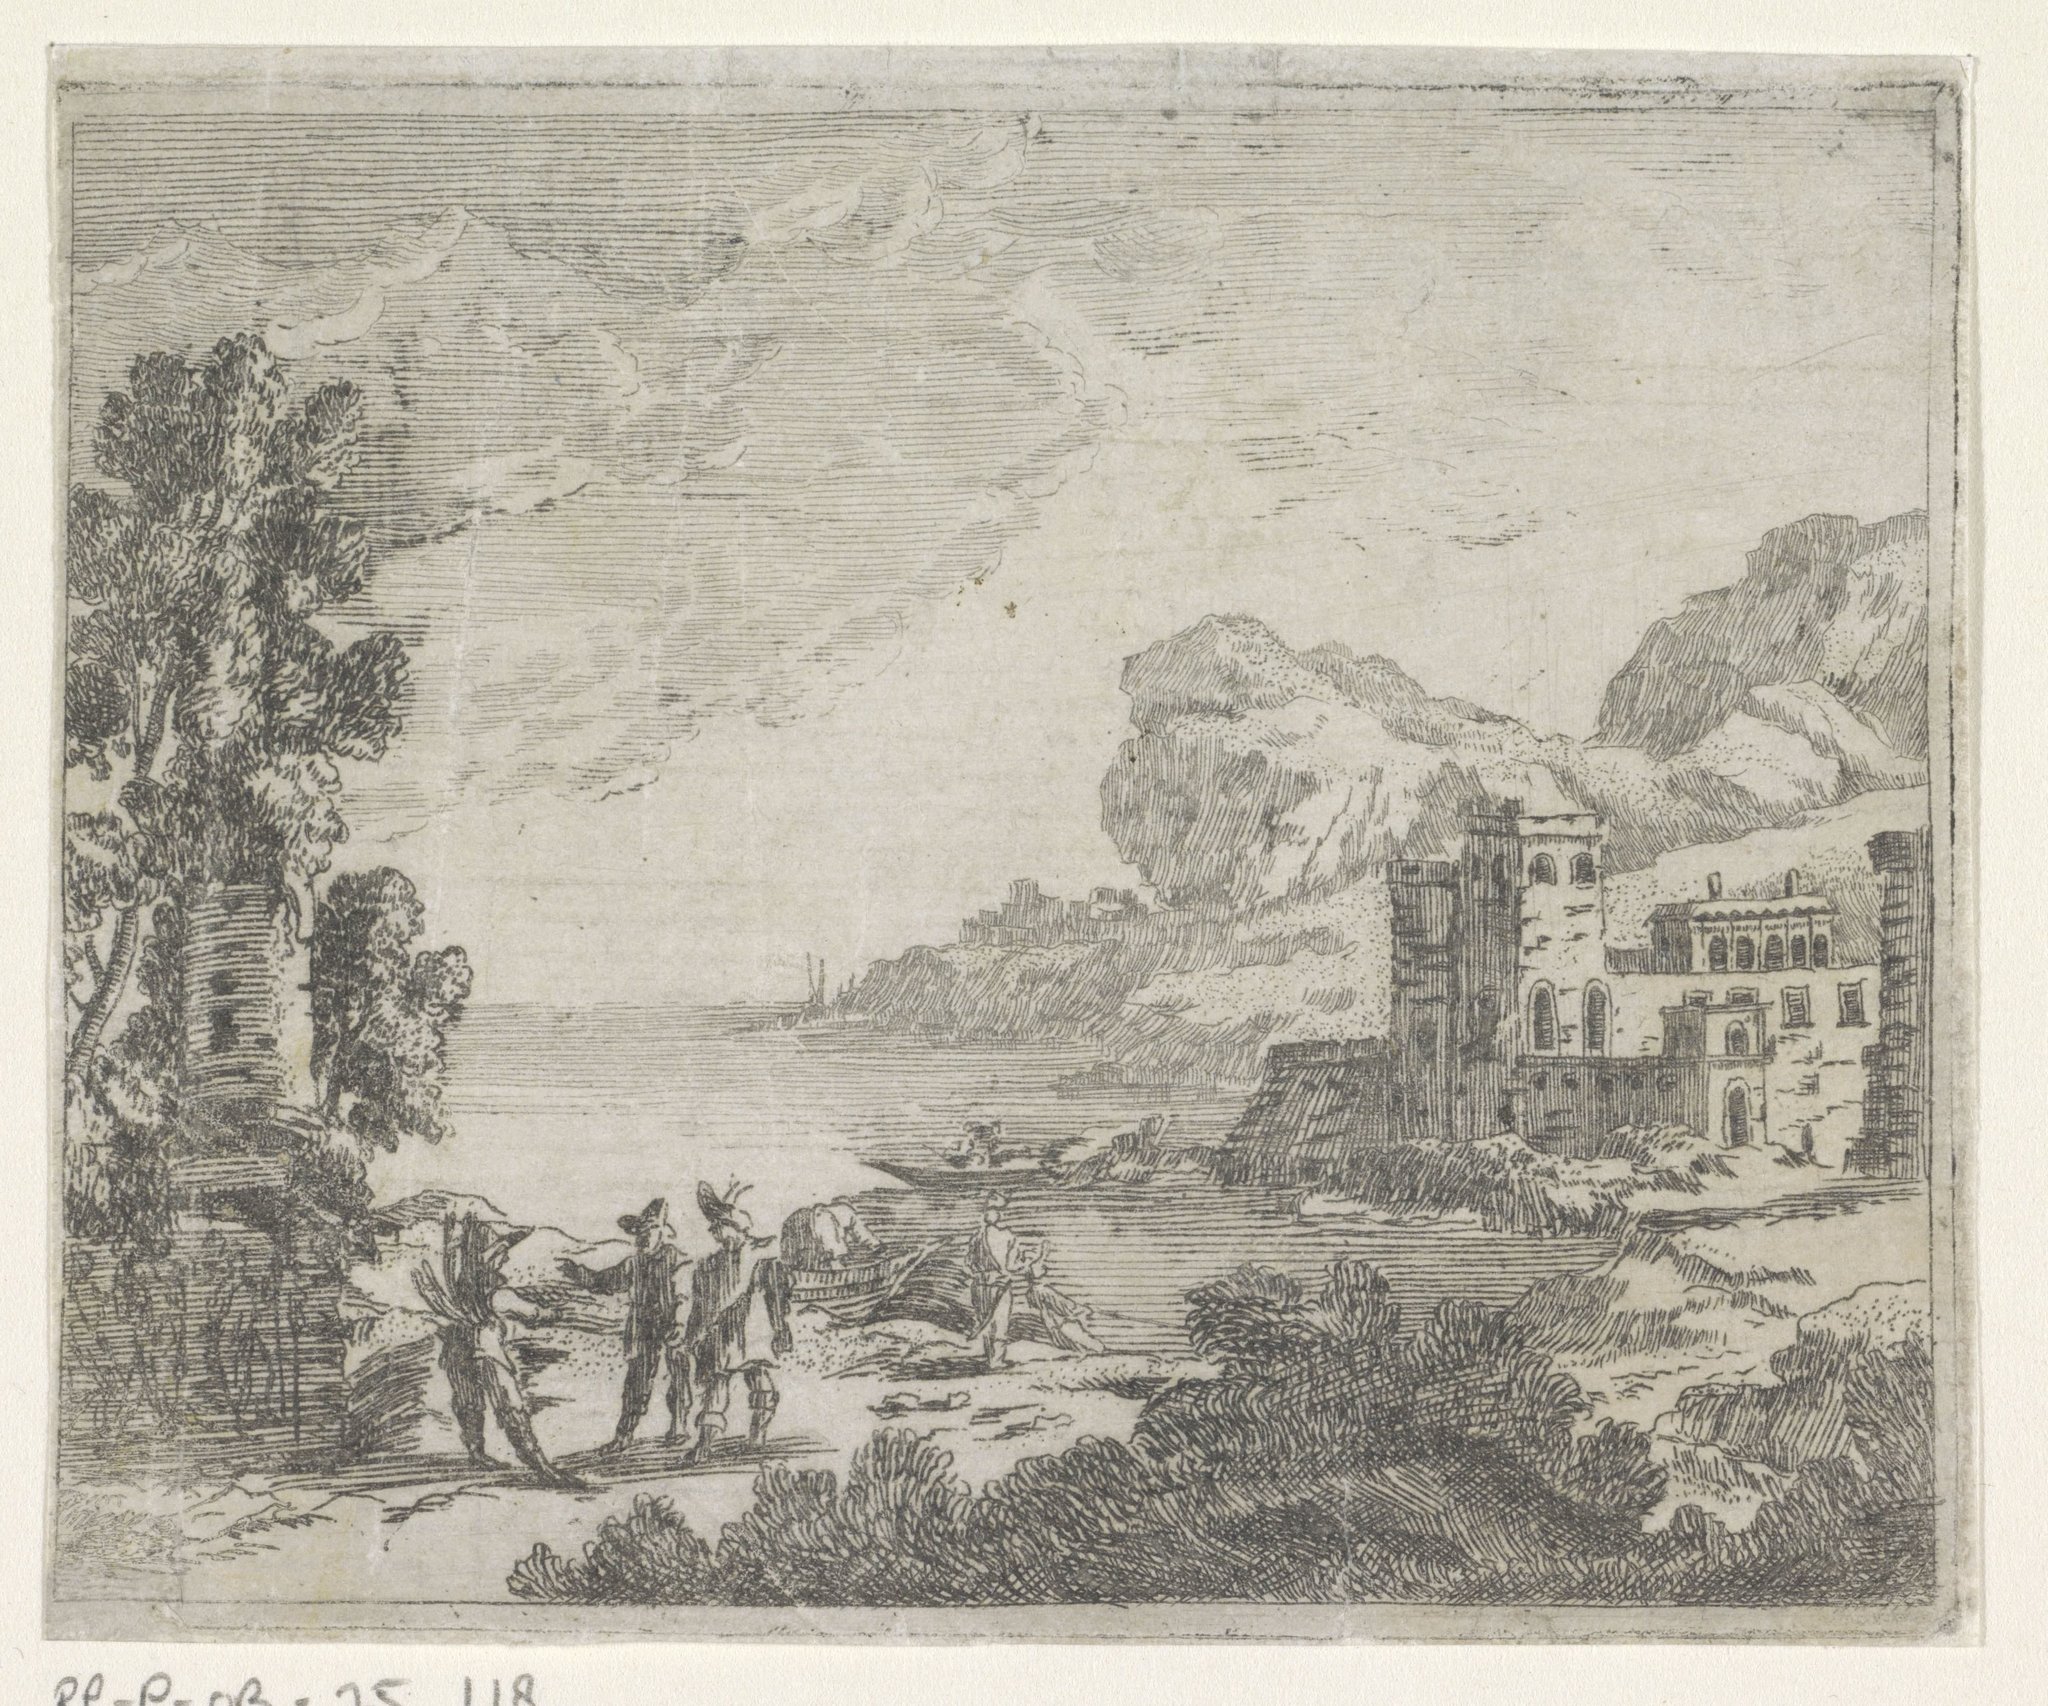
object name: print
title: Kustlandschap met drie figuren op de voorgrond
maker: Anonymous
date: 1700-1800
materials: paper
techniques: etching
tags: coast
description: Kustlandschap met een baai. Aan de baai ligt een gebouw met toren. Op de voorgrond drie figuren.